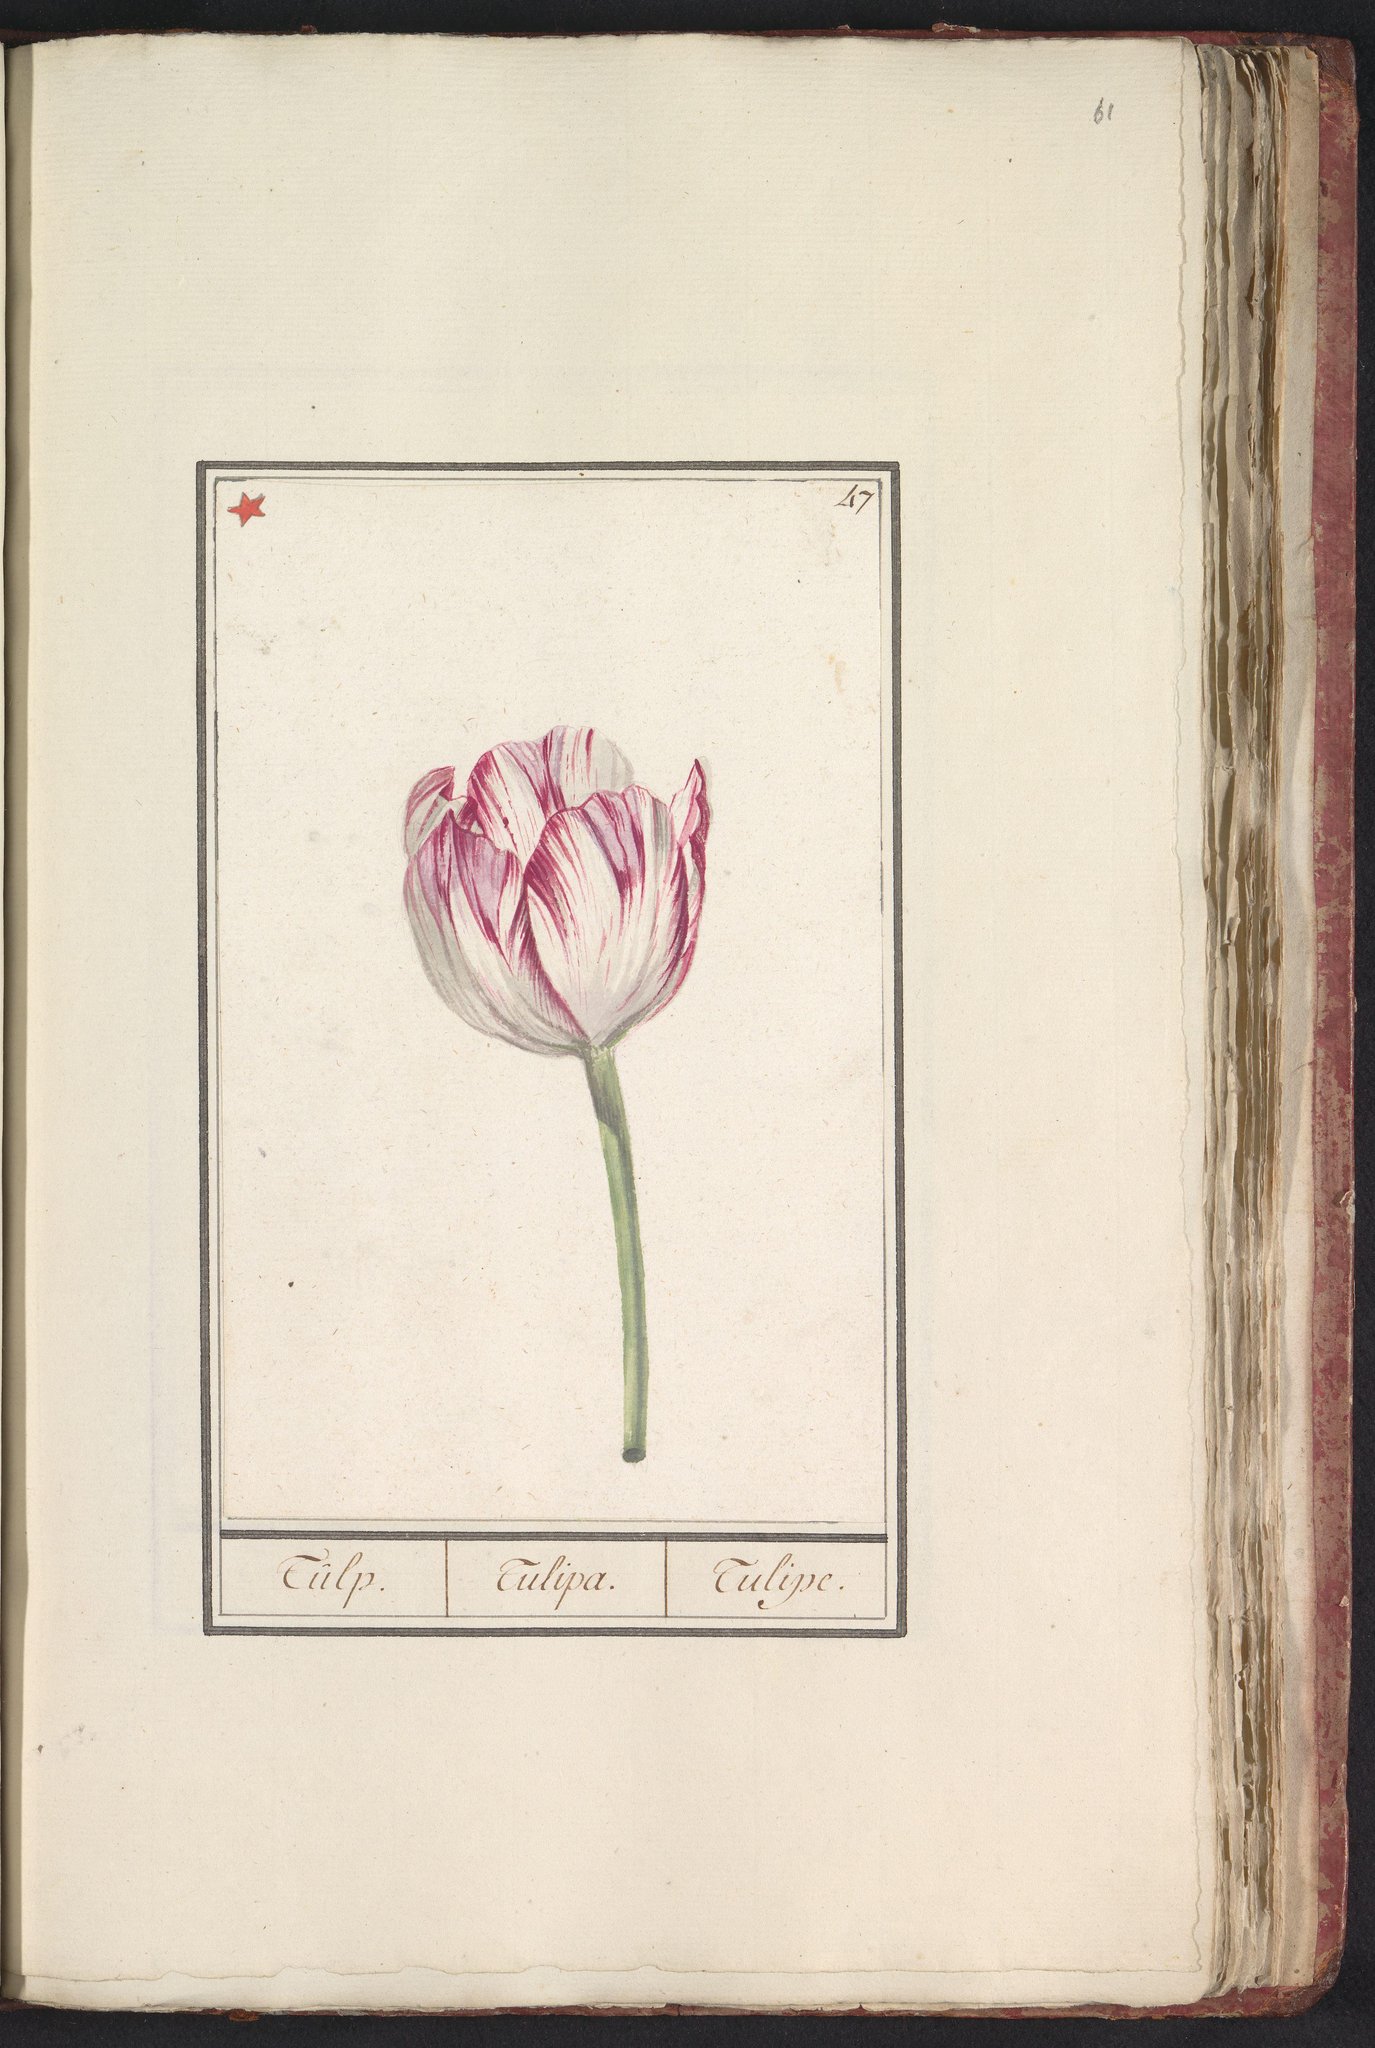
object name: drawing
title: Tulp (Tulipa)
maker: Anonymous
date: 1790-1814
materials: paint, paper, pencil, watercolor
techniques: brush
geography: southern netherlands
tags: flowers: tulip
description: Rood-witte tulp. Genummerd rechtsboven: 47. Linksboven gemerkt met een rood sterretje. Onderdeel van het eerste album met tekeningen van bloemen en planten. Achtste van twaalf albums met tekeningen van dieren, vogels en planten bekend rond 1600, gemaakt in opdracht van keizer Rudolf II. Met toelichting in Nederlands, Latijn en Frans.